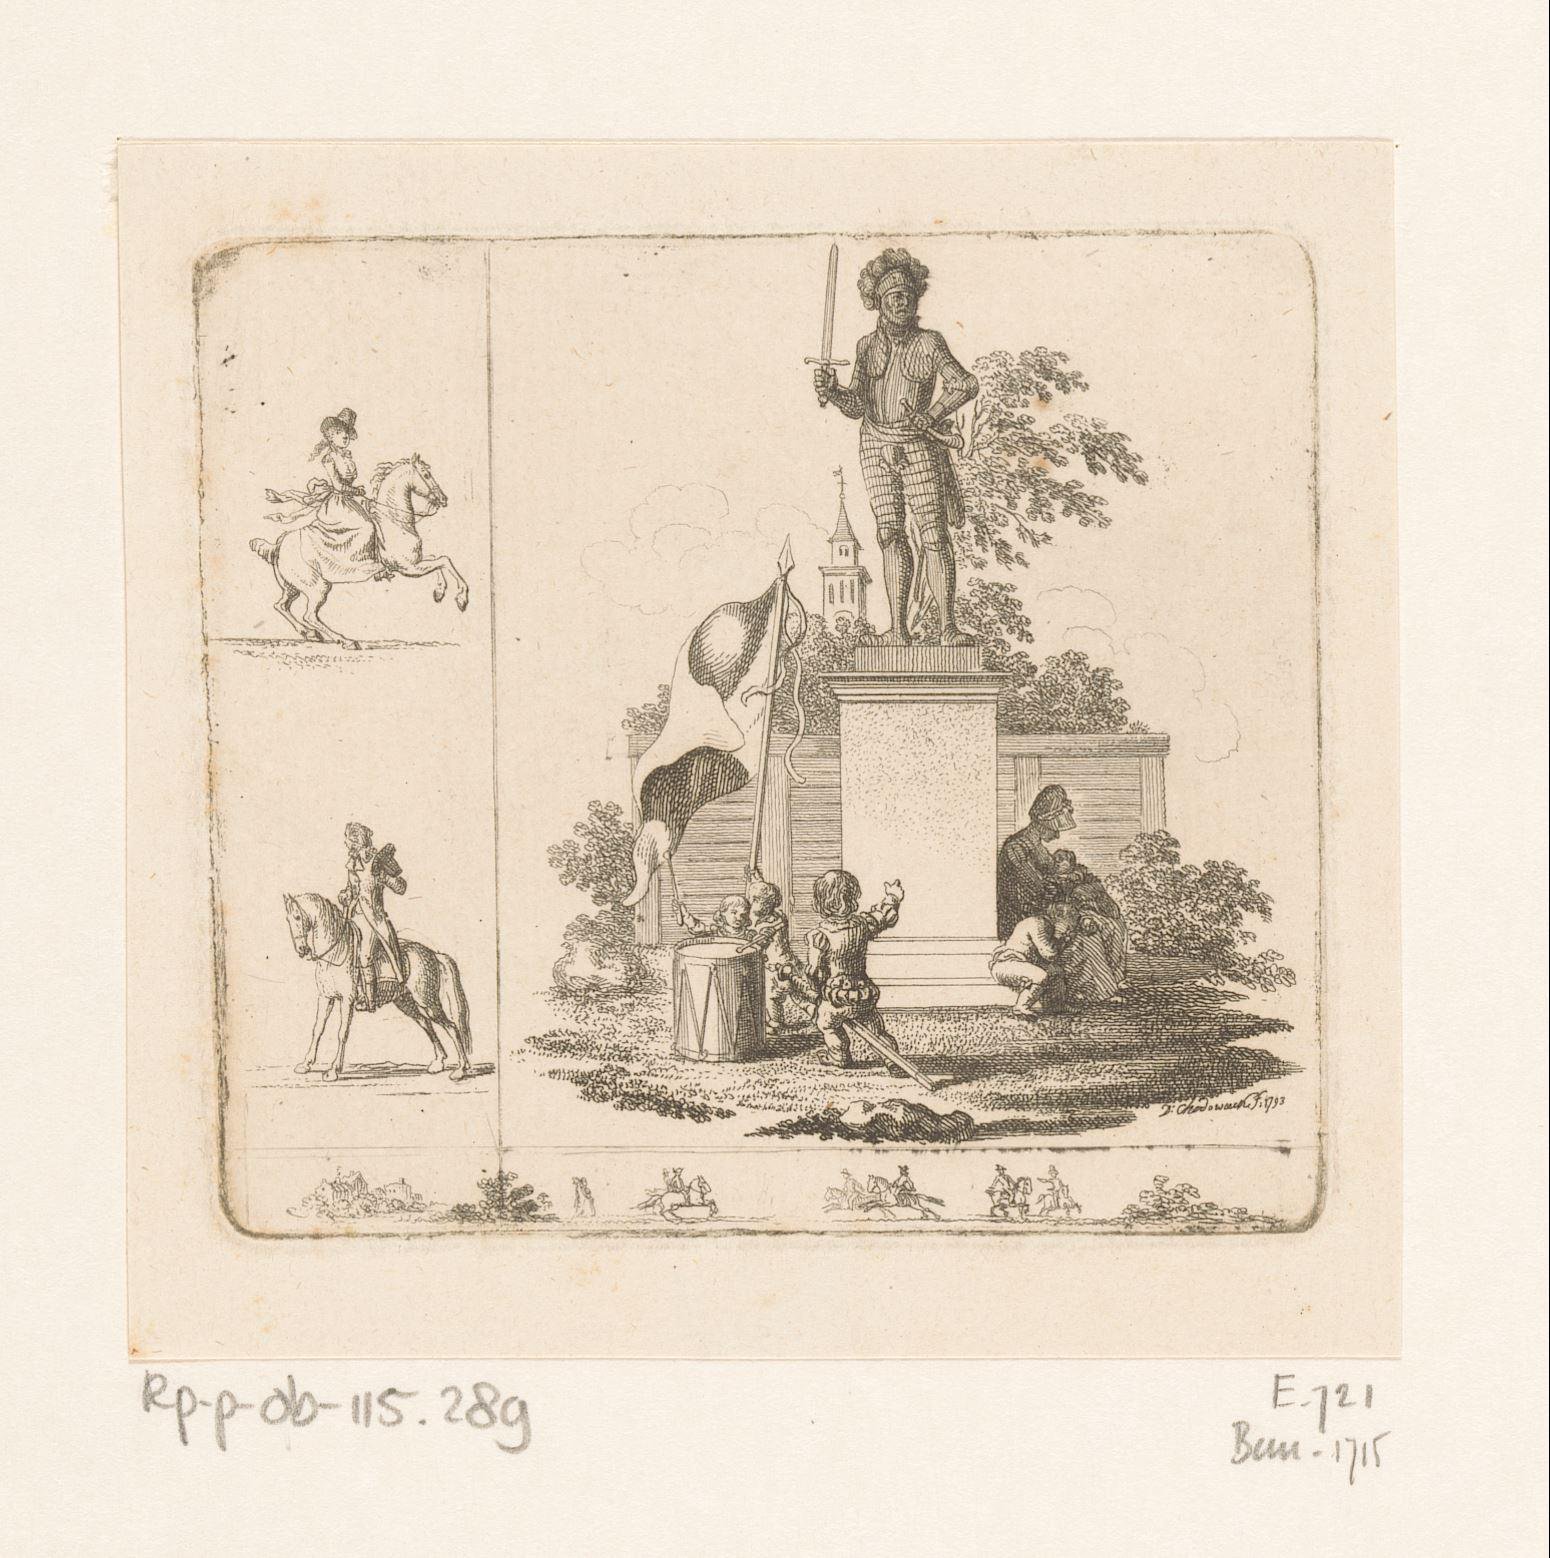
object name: print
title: Verering van het standbeeld van de grote Roland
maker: daniel nikolaus chodowiecki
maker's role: draughtsman, print maker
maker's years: 1726-1801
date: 1793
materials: paper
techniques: etching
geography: berlin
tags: riding a horse, ass, or mule; rider, horseman, breasts giving milk, roland, monument, statue, drum (musical instrument) - cc - out of doors, flag, colours (as symbol of the state, etc.)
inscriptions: collector's mark: Lugt 2228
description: Latere staat gebruikt voor: Wächter, Leonhard. Historien von Leonhard Waechter (...). Hamburg: Bachmann und Gundermann, 1794.